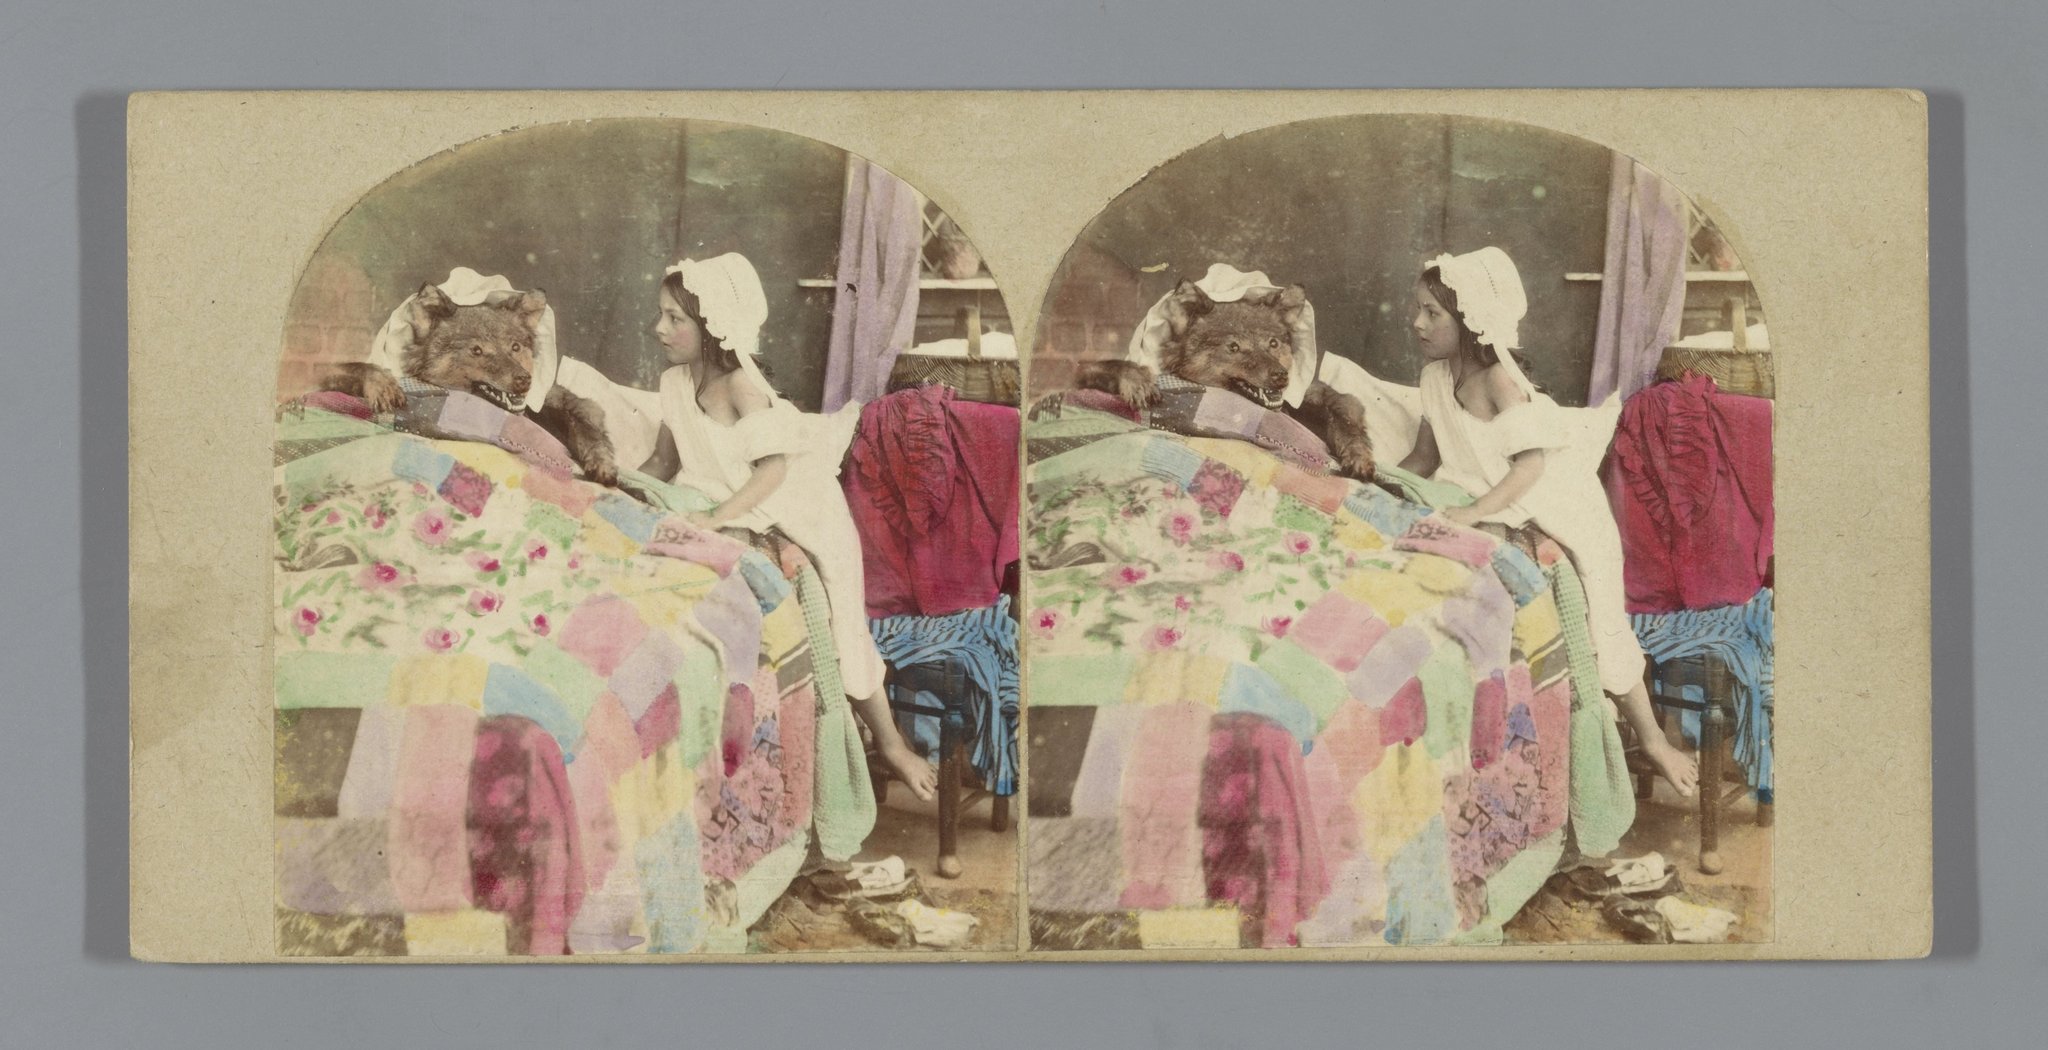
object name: stereograph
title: Little Red Riding Hood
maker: Anonymous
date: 1852-1863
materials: cardboard, paper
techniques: albumen print, hand coloring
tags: tales and fairy tales: little red riding-hood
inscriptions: inscription: ‘Registered.’, number: ‘65’